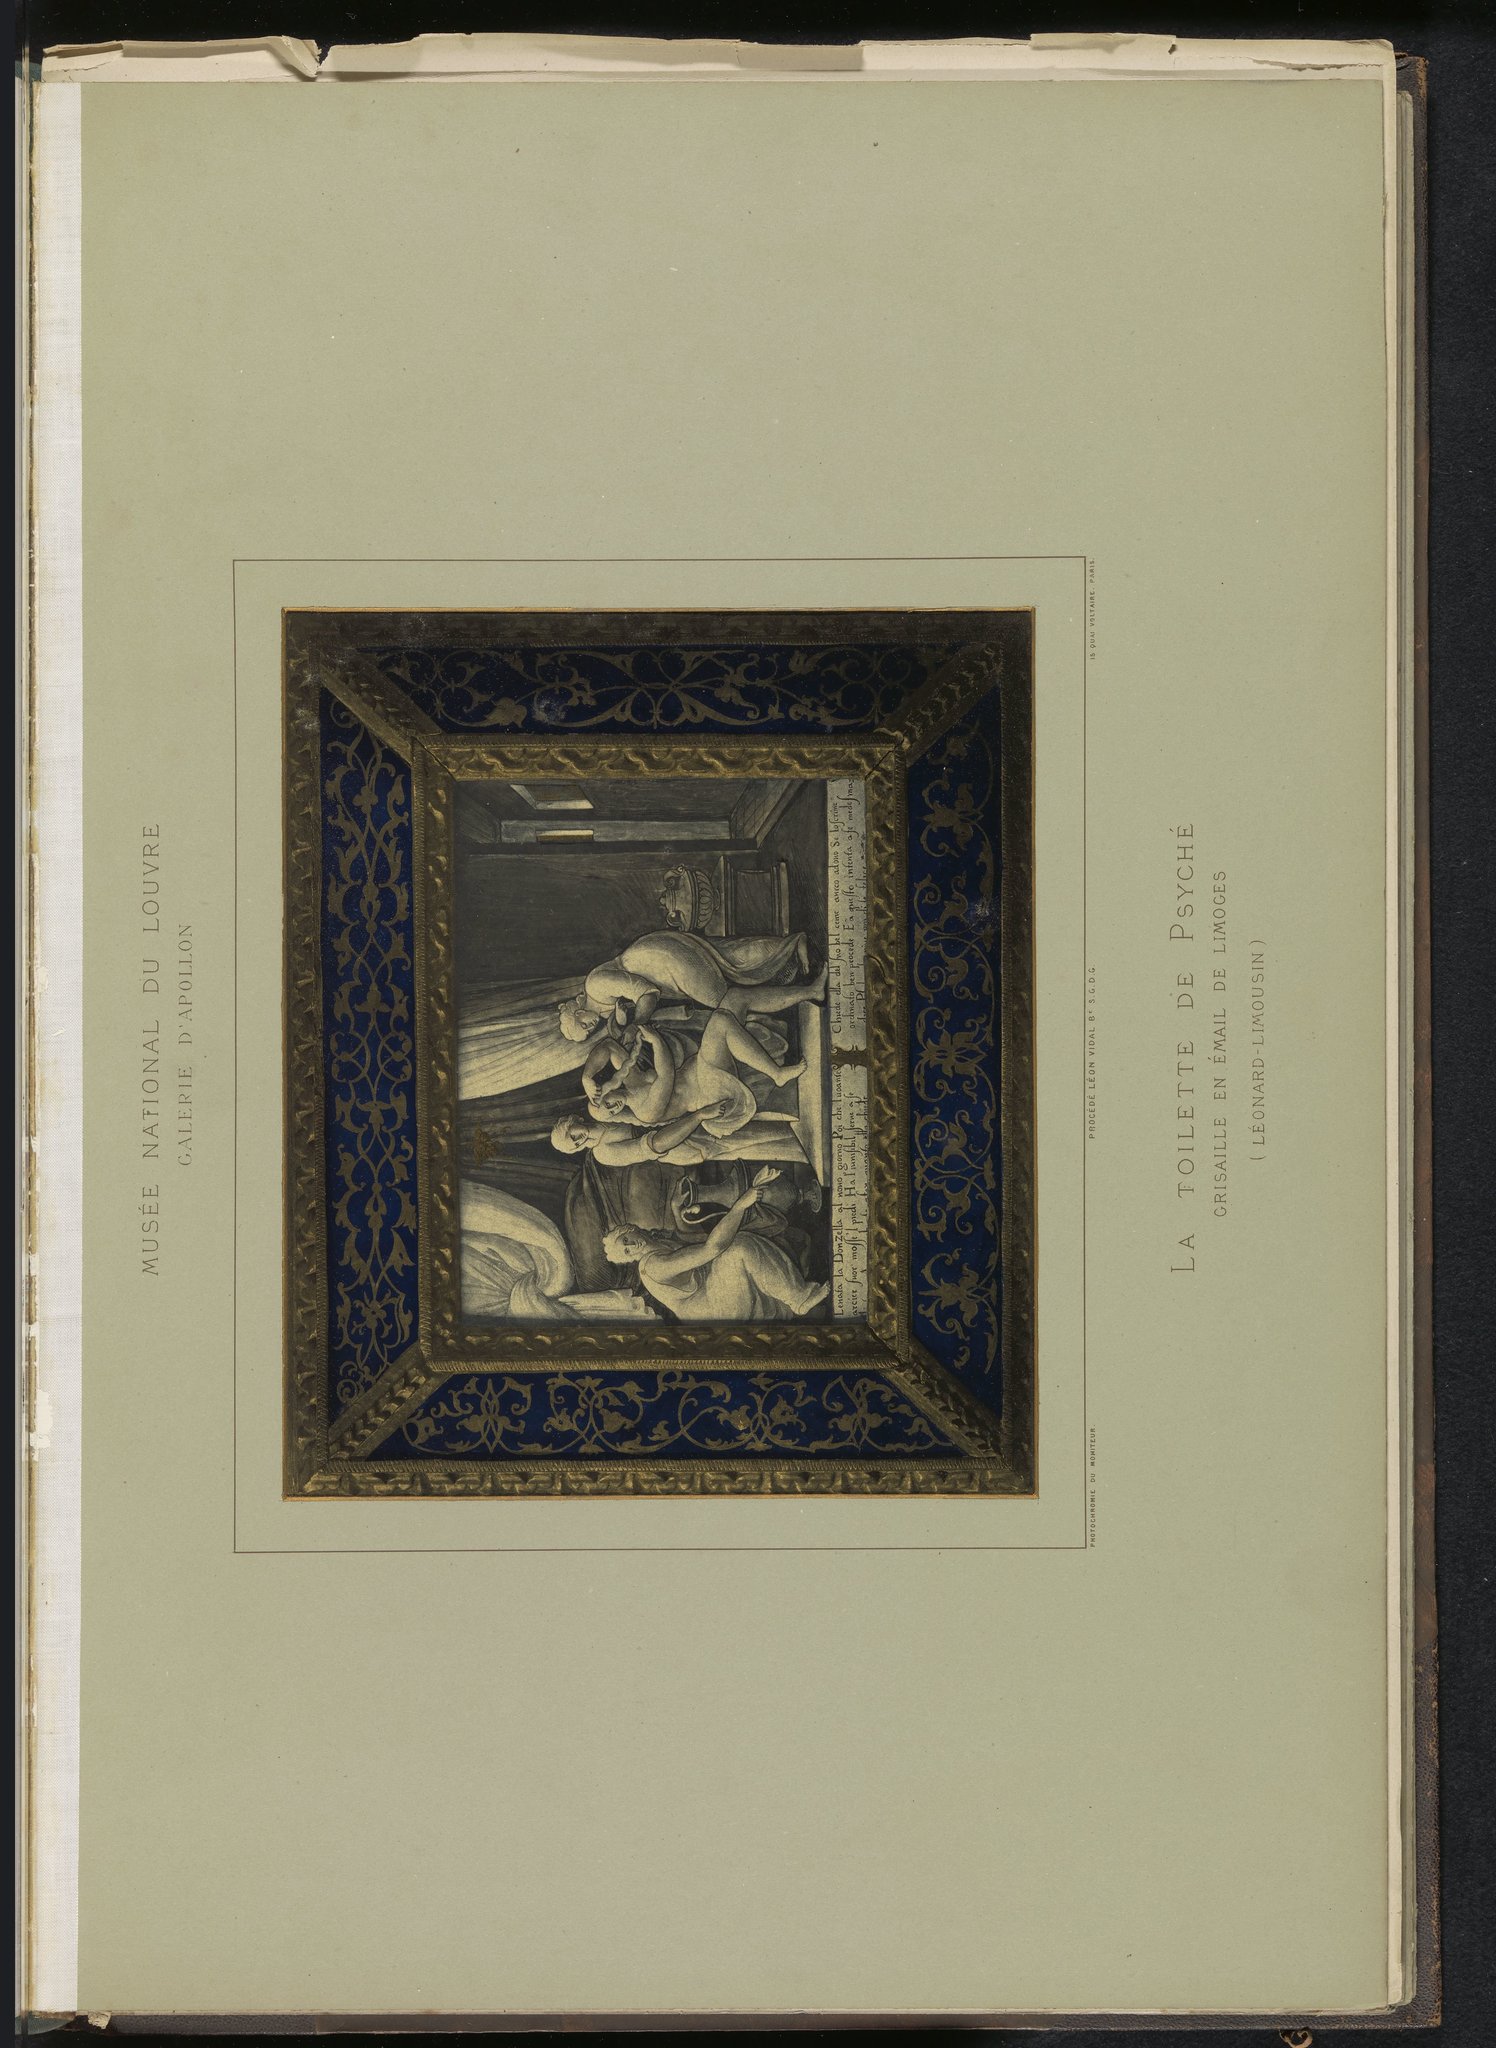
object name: page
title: Musée National du Louvre Galerie d'Apollon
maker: léon vidal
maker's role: fotograaf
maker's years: 1833-1906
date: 1876-1883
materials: paper, photographic process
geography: paris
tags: psyche is attended by invisible hands; the toilet of psyche, picture, painting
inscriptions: inscription: ‘photochromie du moniteur’